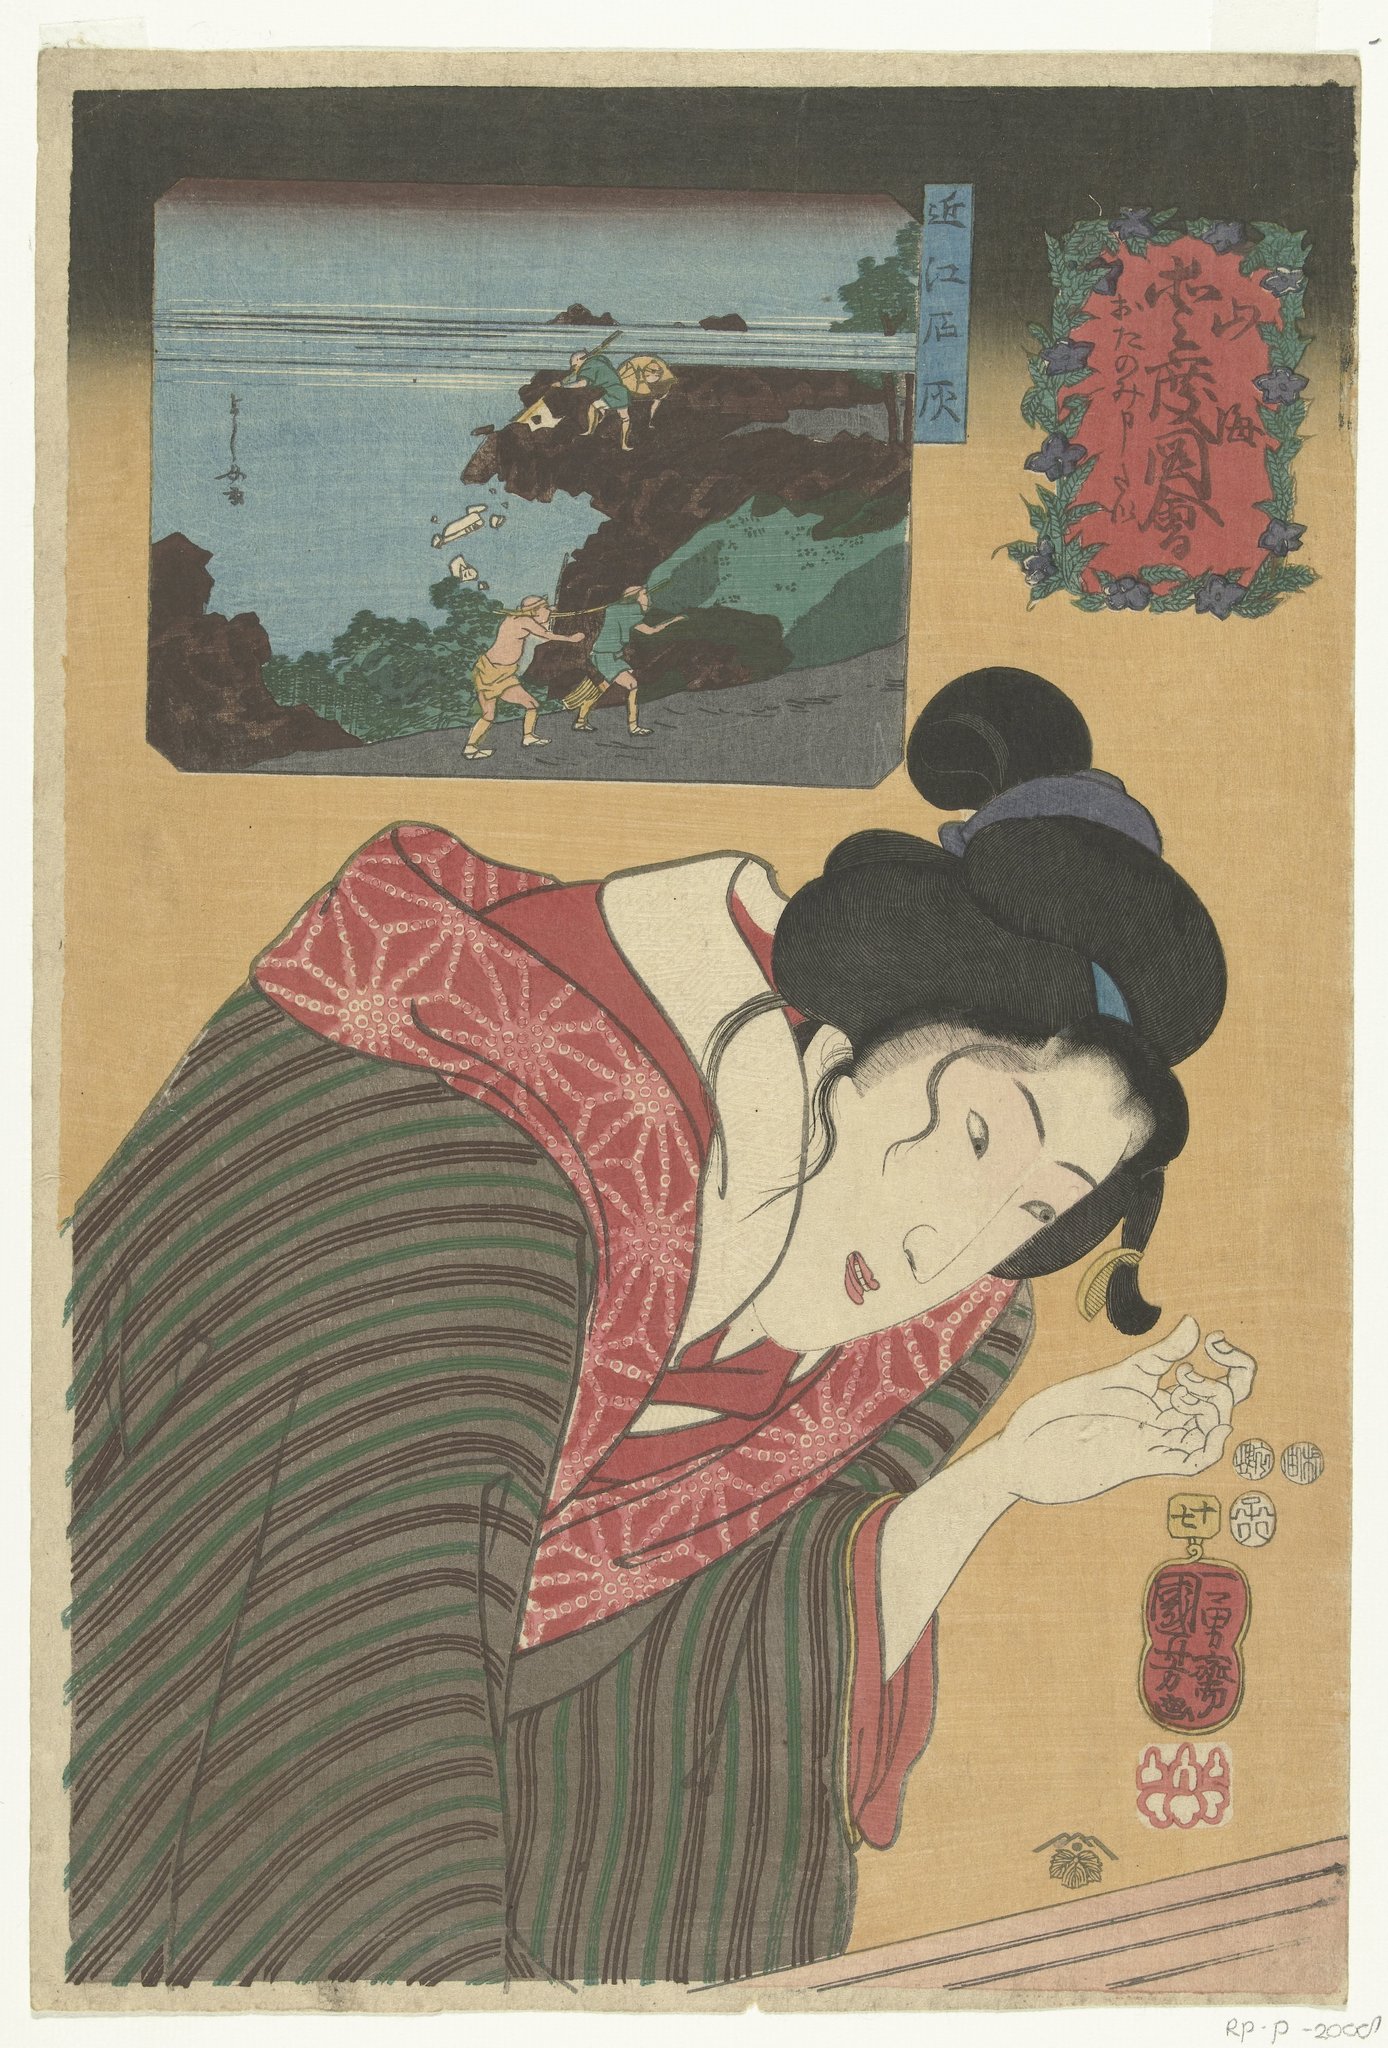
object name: print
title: Warme gevoelens voor berg en zee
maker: utagawa kuniyoshi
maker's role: draughtsman, print maker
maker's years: 1798-1861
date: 1804-1852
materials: paper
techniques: woodcut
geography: japan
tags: lime works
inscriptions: date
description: Voorovergebogen vrouw, de hand reikend naar kammetje in haarlok. Cartouche linksboven met gezicht op rotslandschap waarin vier mannen kalk winnen.